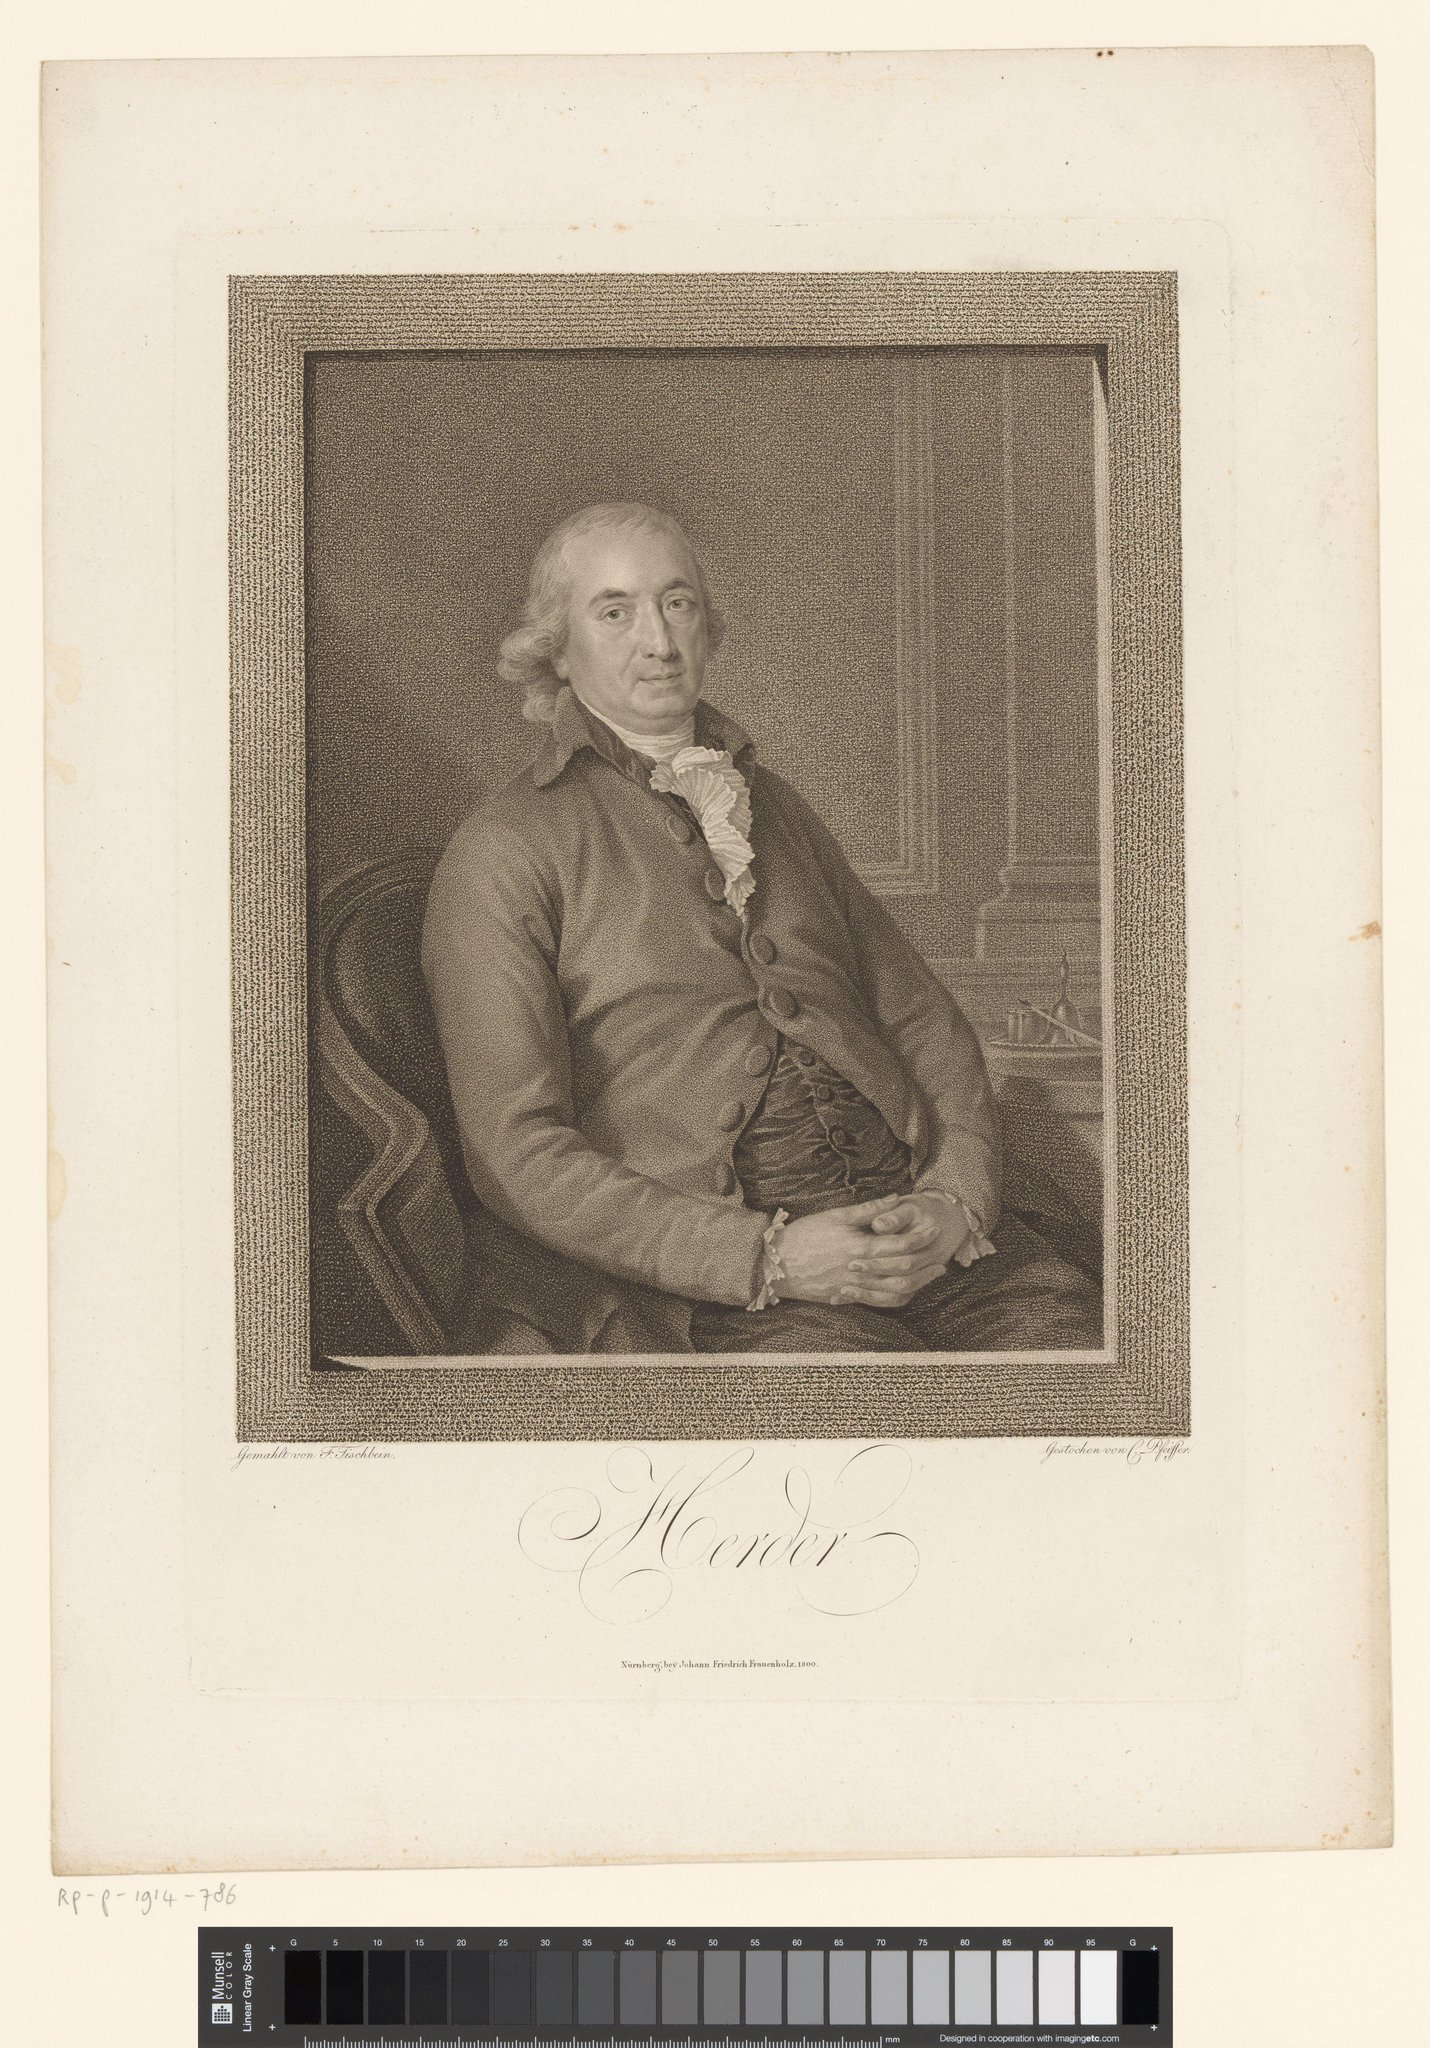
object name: print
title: Portret van Johann Gottfried von Herder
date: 1800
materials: paper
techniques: stippled etching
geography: nuremberg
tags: historical persons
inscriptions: collector's mark: Lugt 2228